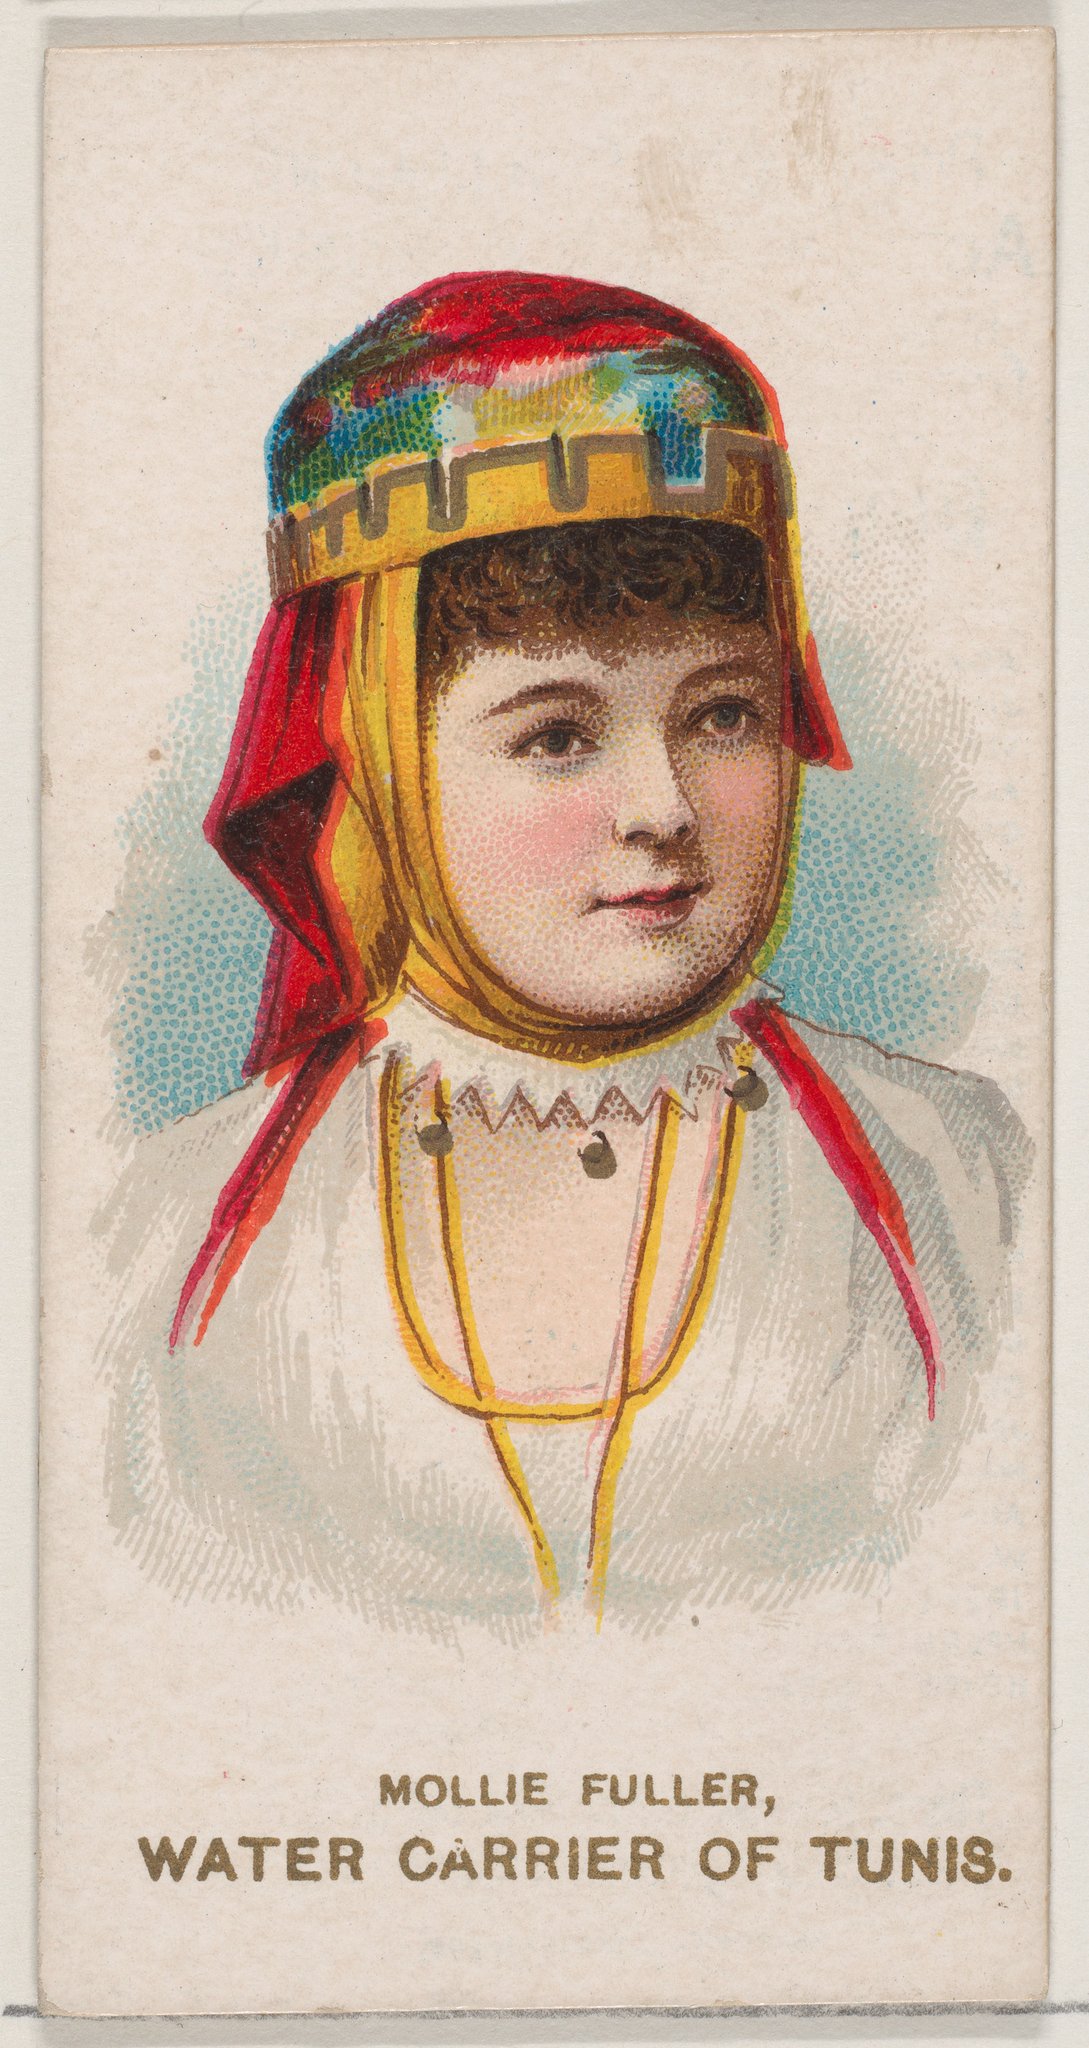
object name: print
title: Mollie Fuller as a Water Carrier of Tunis, from the set Actors and Actresses, Second Series (N71) for Duke brand cigarettes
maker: w. duke, sons & co.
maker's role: publisher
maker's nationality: american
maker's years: 1870-1920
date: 1888-1890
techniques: color lithograph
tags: women,actresses